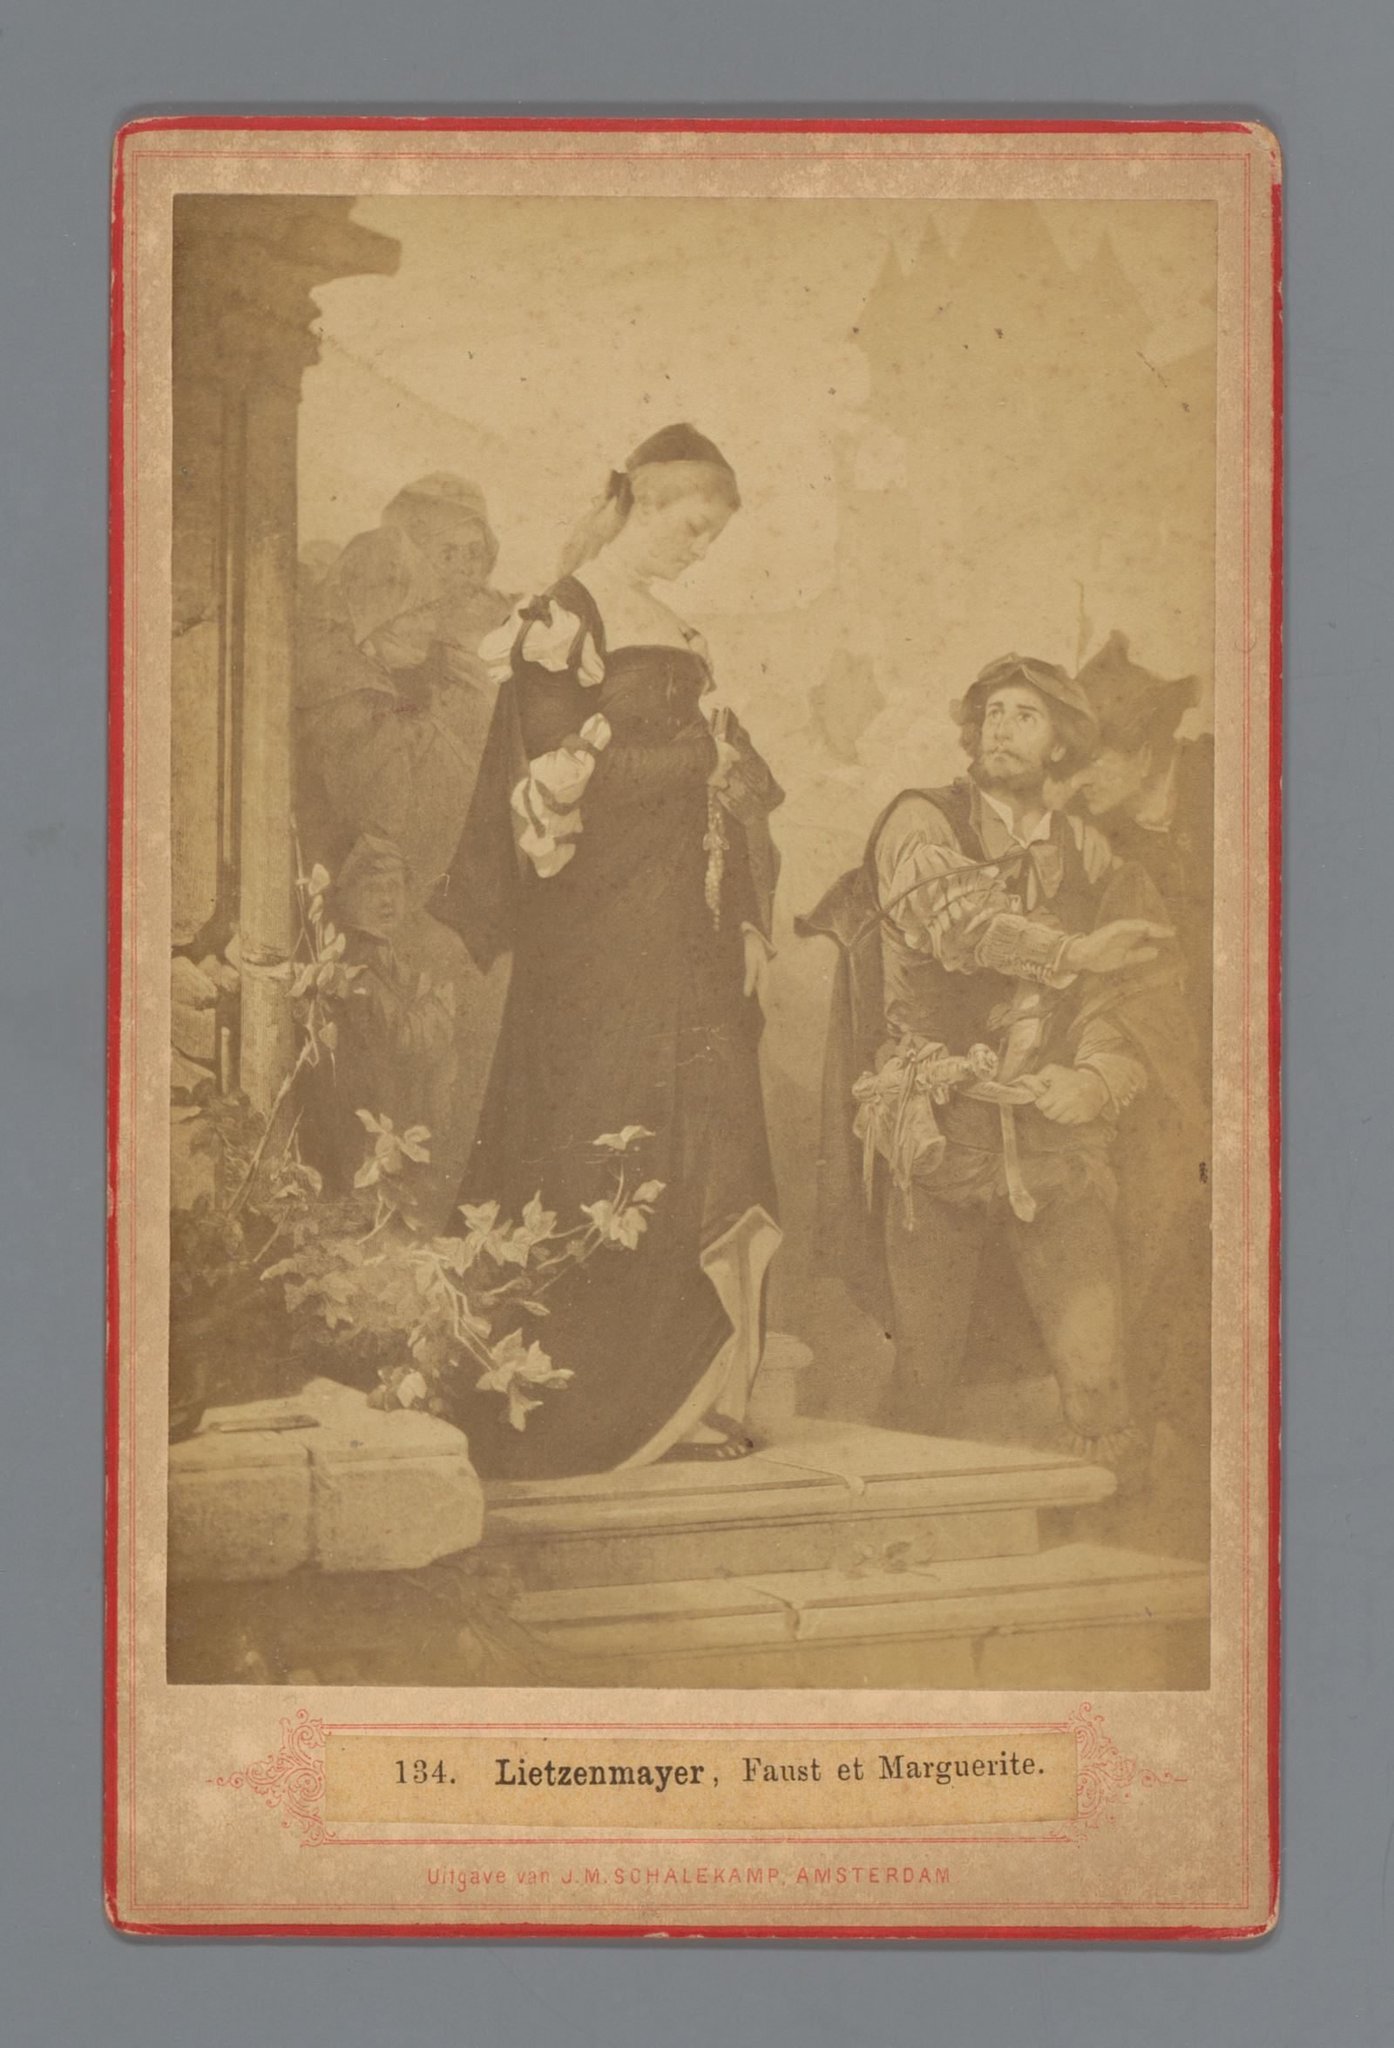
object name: reproduction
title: Faust et Marguerite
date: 1875-1890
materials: cardboard, photographic support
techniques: albumen print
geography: amsterdam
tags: leaving the church after service, (scenes from) specific works of literature: goethe, faust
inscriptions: inscription: ‘[...] Kunsthandelaar Bakkerstraat 70 Arnhem’